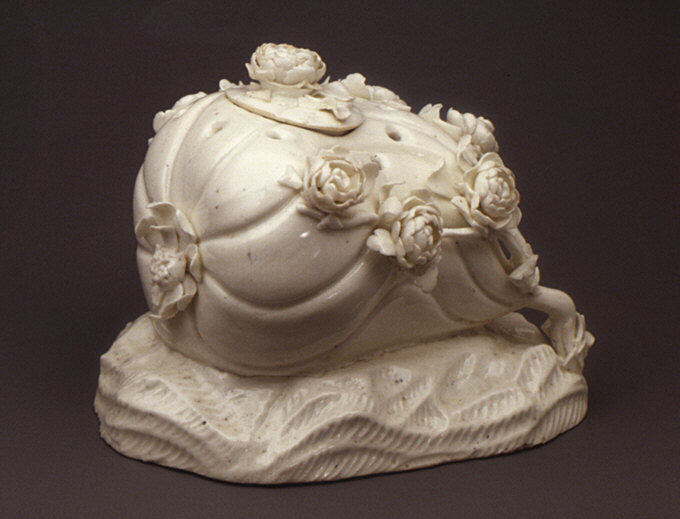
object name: potpourri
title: Potpourri (one of a pair)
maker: saint-cloud factory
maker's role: factory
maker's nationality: french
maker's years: 1693-1766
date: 1730-1750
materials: soft paste porcelain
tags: flowers